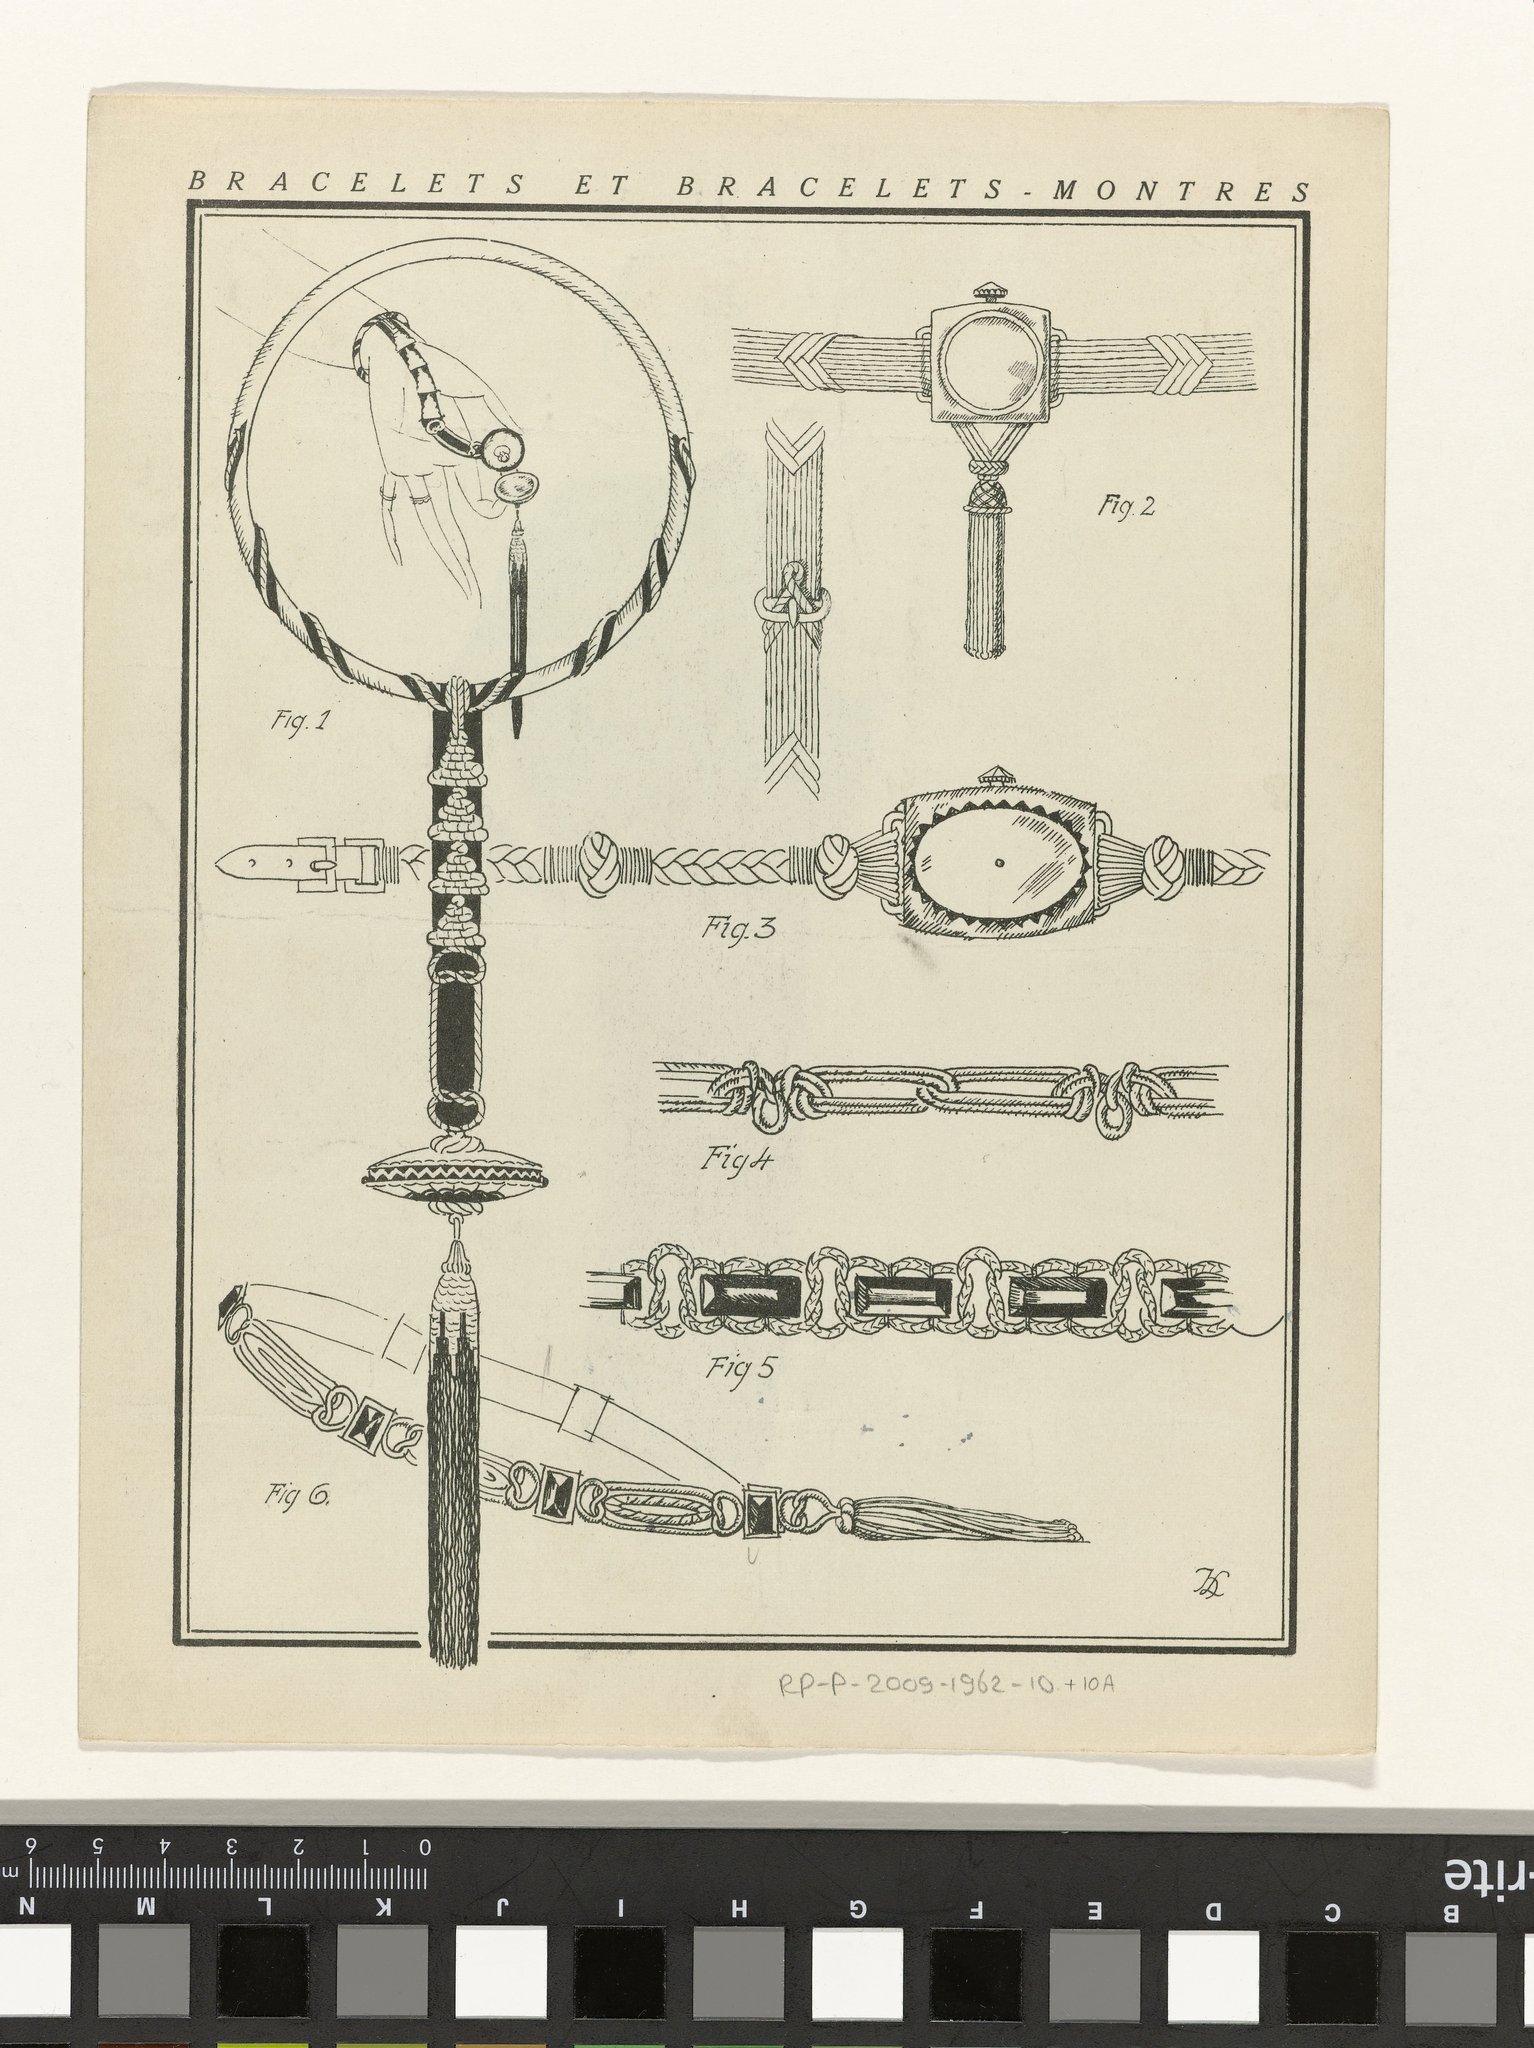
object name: fashion print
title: Accessories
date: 1922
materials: paper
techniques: letterpress printing, lithograph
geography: new york city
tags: fashion plates, watch, bracelet, wristlet (+ women's clothes)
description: Fans, parasols, opera gloves, fashionable hats, small toques garnished with feathers, wristwatches, compact bracelets, and luxuriously crafted lighters: there was a dazzling variety of accessories in the 1920s. Small bags could be suspended from a belt, or a glove. Walking sticks and the shafts of umbrellas and parasols were often embellished with carving clearly inspired by African and Indian art. And Russian influence was evident when it came to combs made of mother-of-pearl and ivory.